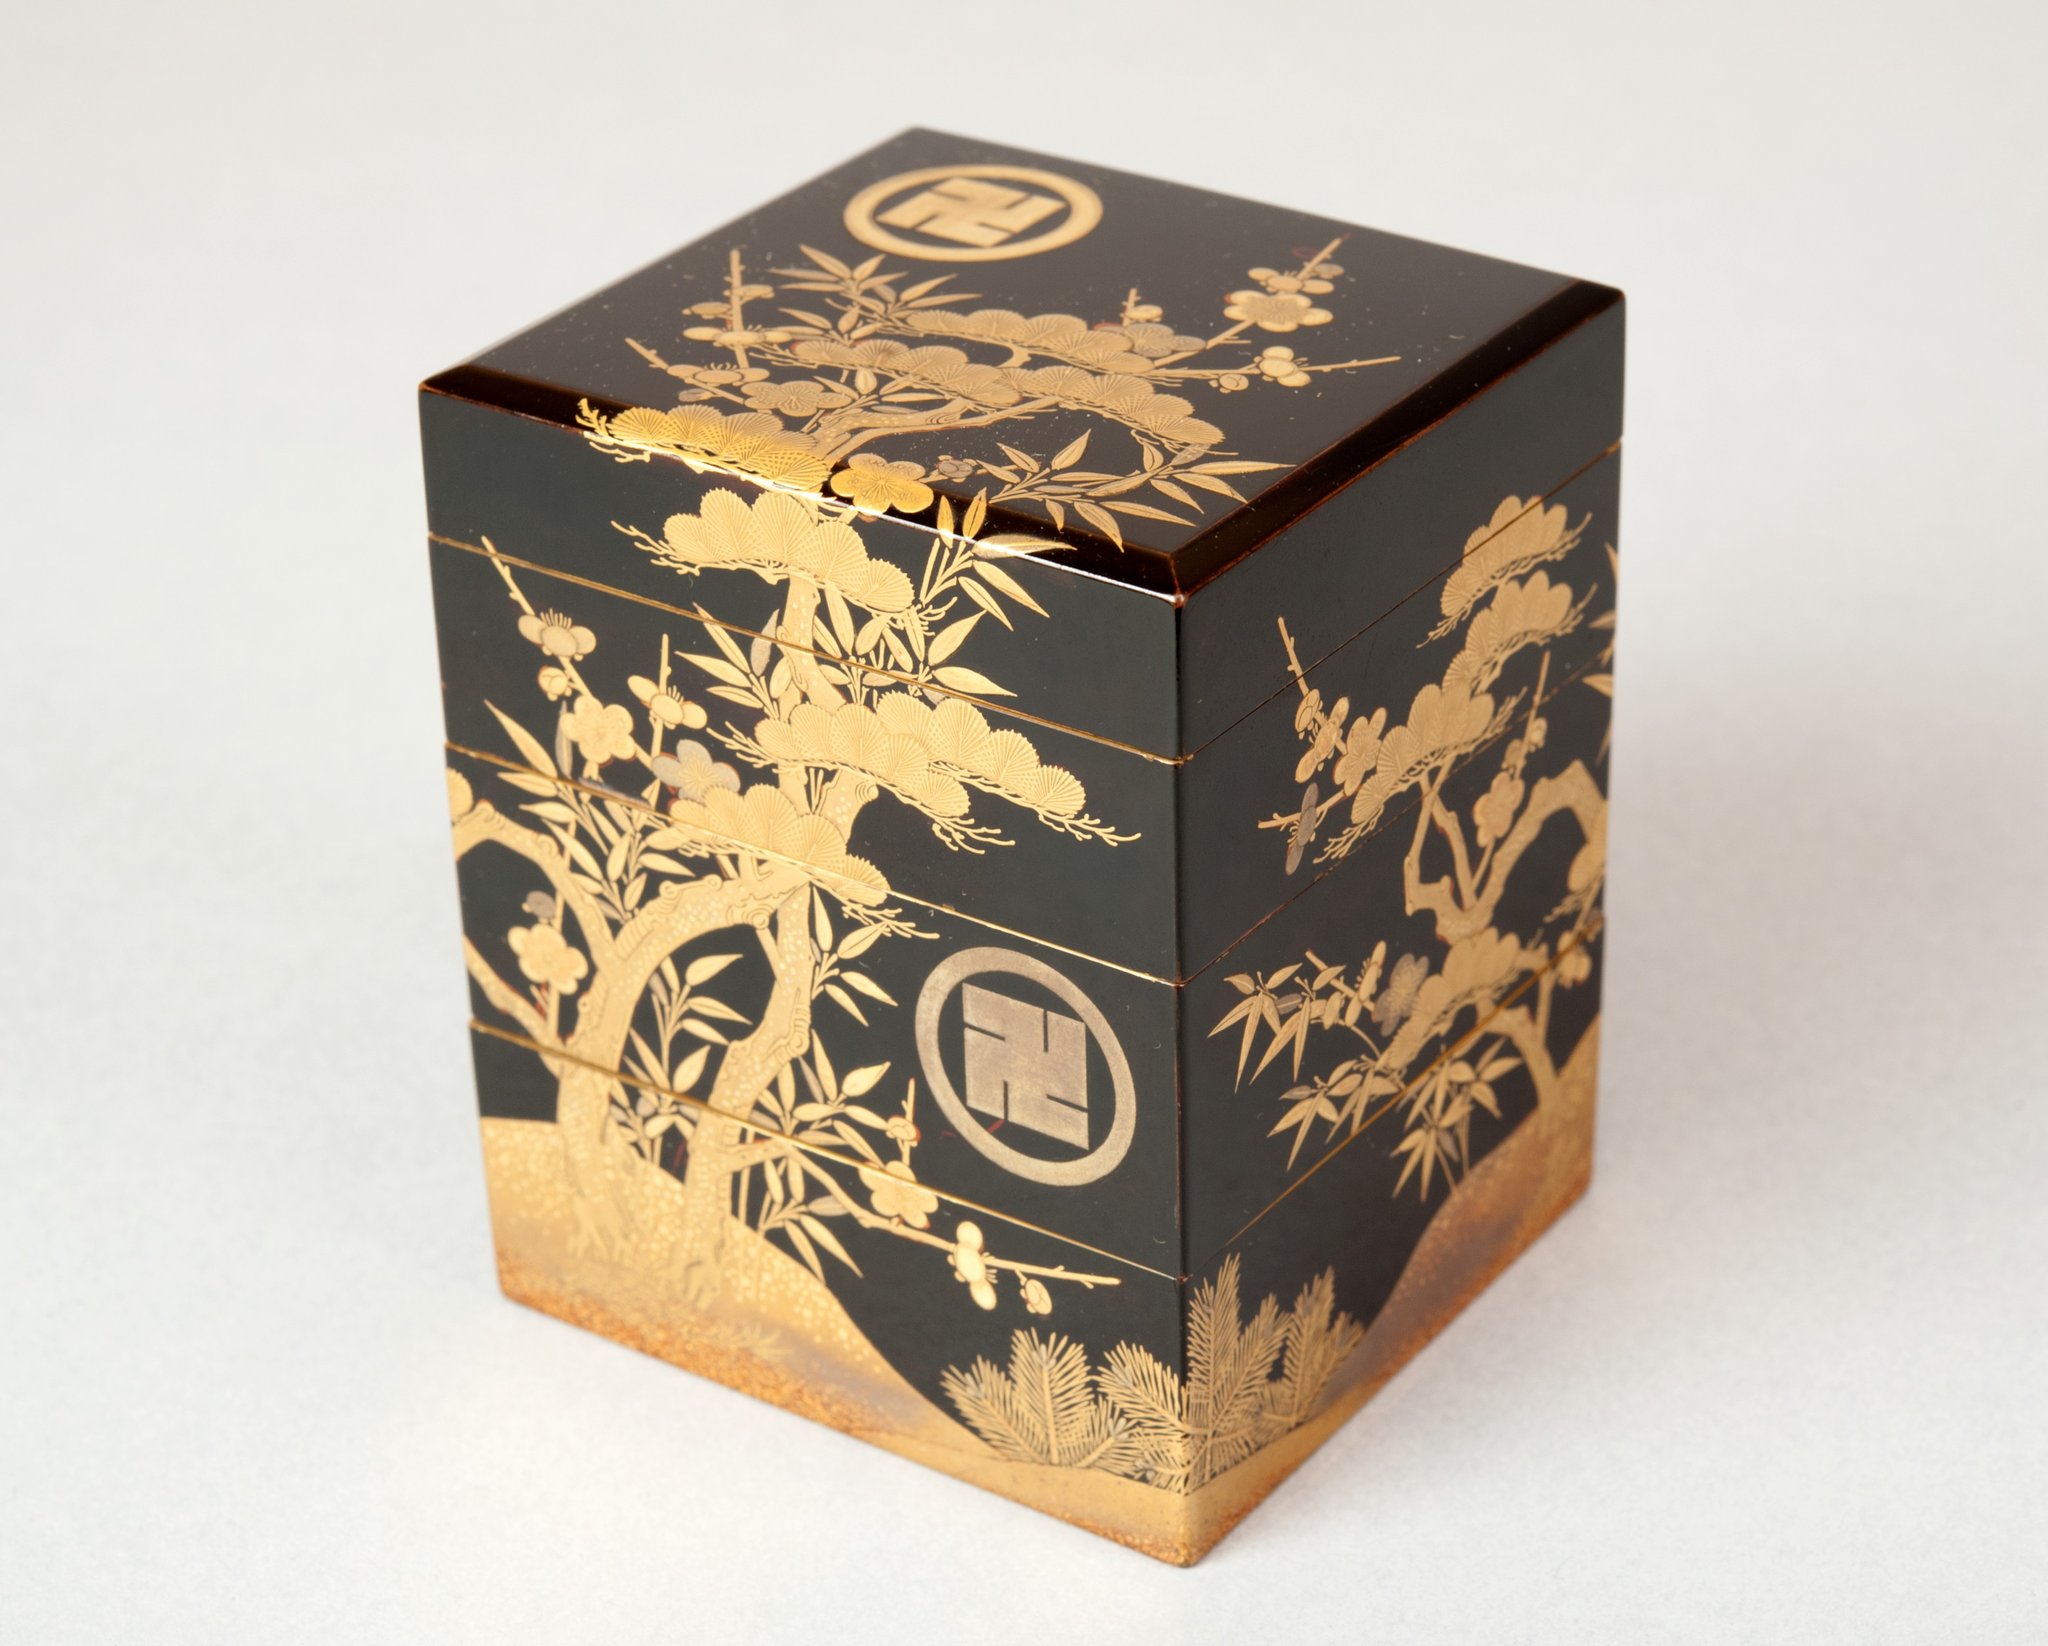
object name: box with cover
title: Tiered Incense Box (Jūkōgō) with Family Crest, Pine, Bamboo, and Plum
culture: japanese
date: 1701-1800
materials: gold, lacquer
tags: bamboo,emblems